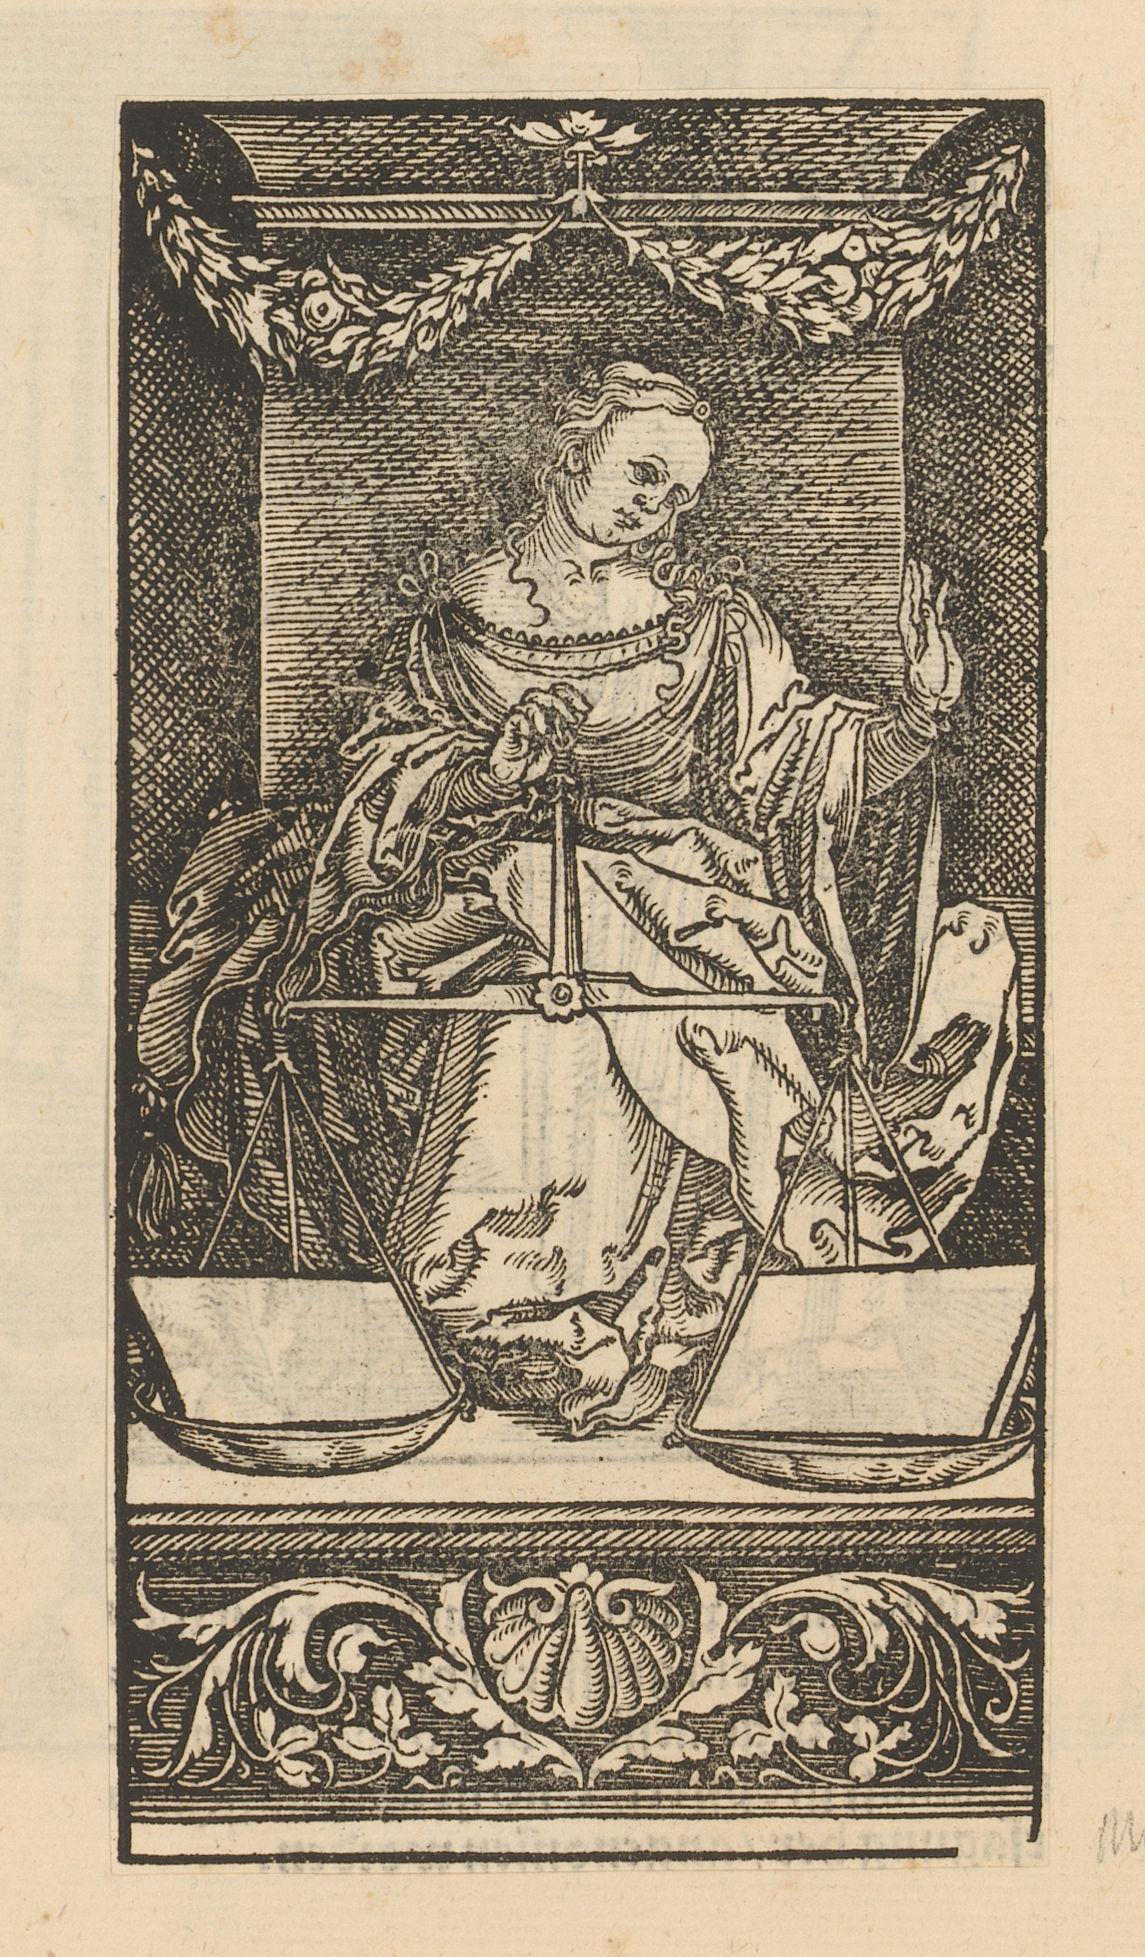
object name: album leaf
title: Vrouw weegt het innerlijke tegen het uiterlijke af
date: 1514-1531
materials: paper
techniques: letterpress printing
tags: balance, equilibrium (+ symbolical representation of concept), judgment of conduct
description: Deze prent is gebruikt in: Cicero, Marcus Tulius. Officia M.T.C. Ein Buch so Marcus Tullius Cicero der Römer zu seynem (...). [Vertaald uit het Latijn door] Johann von Schwarzenberg. Augsburg: Heinrich Steiner, 1531.